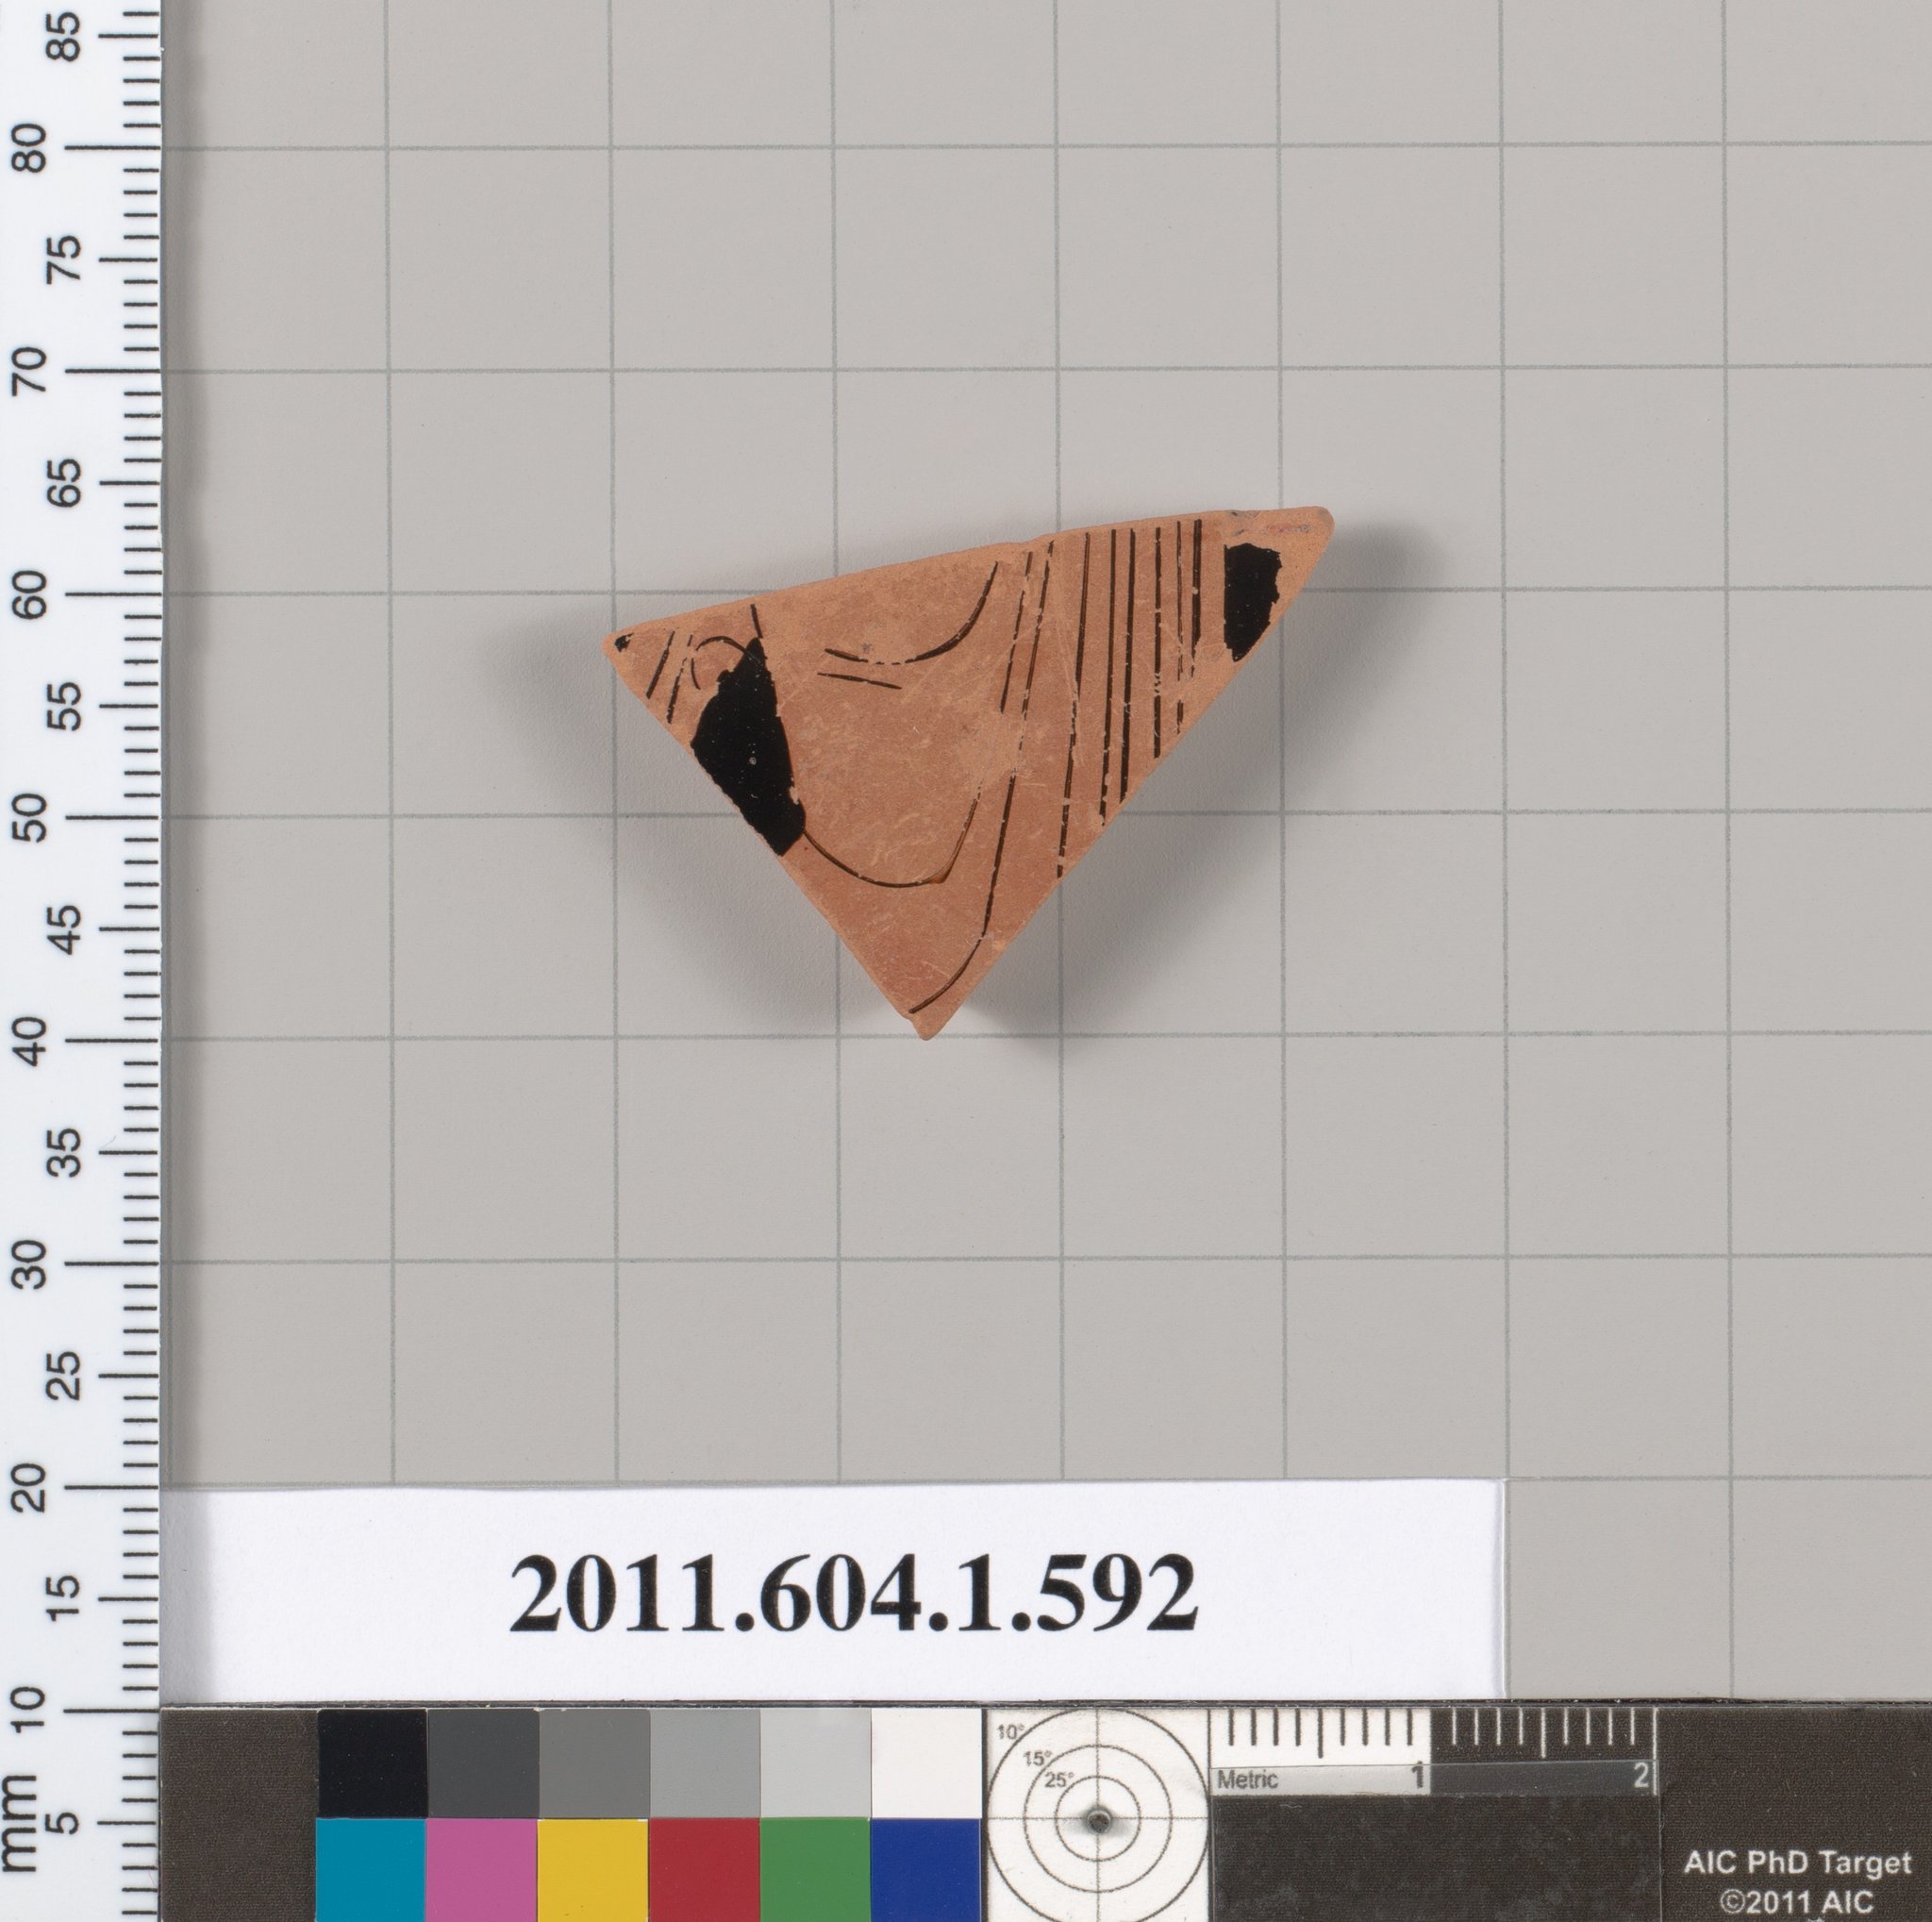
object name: kylix fragment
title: Terracotta fragment of a kylix (drinking cup)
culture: greek, attic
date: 475-451 BCE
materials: terracotta